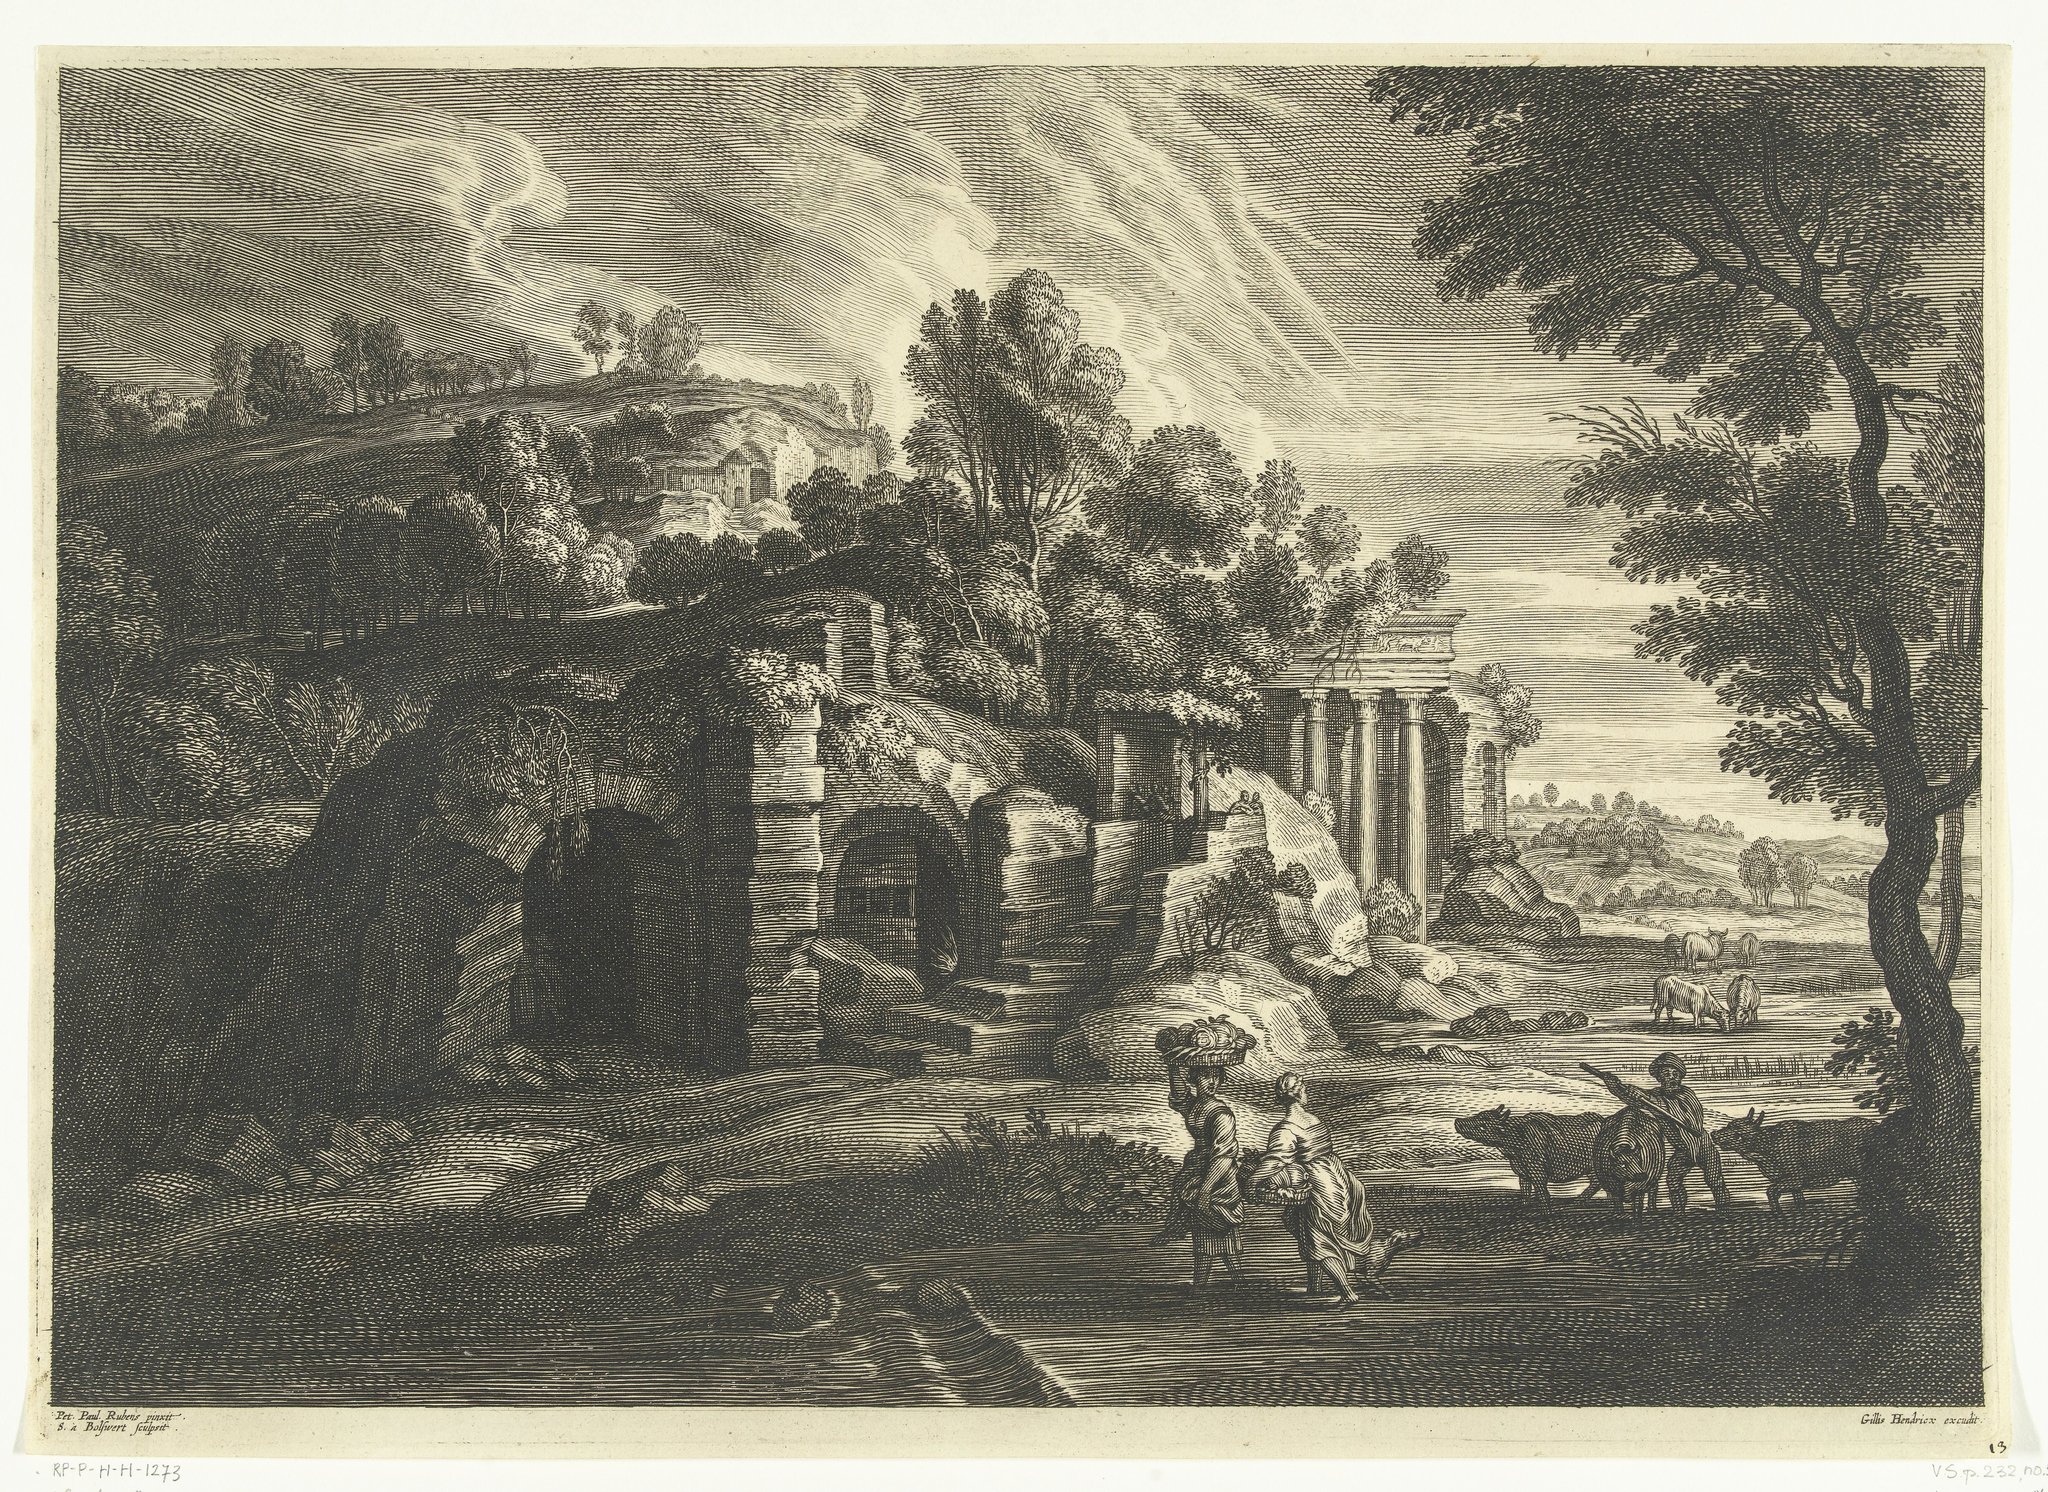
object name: print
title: Landschap met ruïnes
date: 1596-1659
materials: paper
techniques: engraving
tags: landscape with ruins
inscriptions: collector's mark: Lugt 11, inscription: ‘B 29 - 39.58’, collector's mark: Lugt 10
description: Prent naar schilderij van Peter Paul Rubens. Hollstein beschrijft een serie kleine landschappen onder de nrs. 305 t/m 325 maar deze prenten zijn niet als reeks vervaardigd.